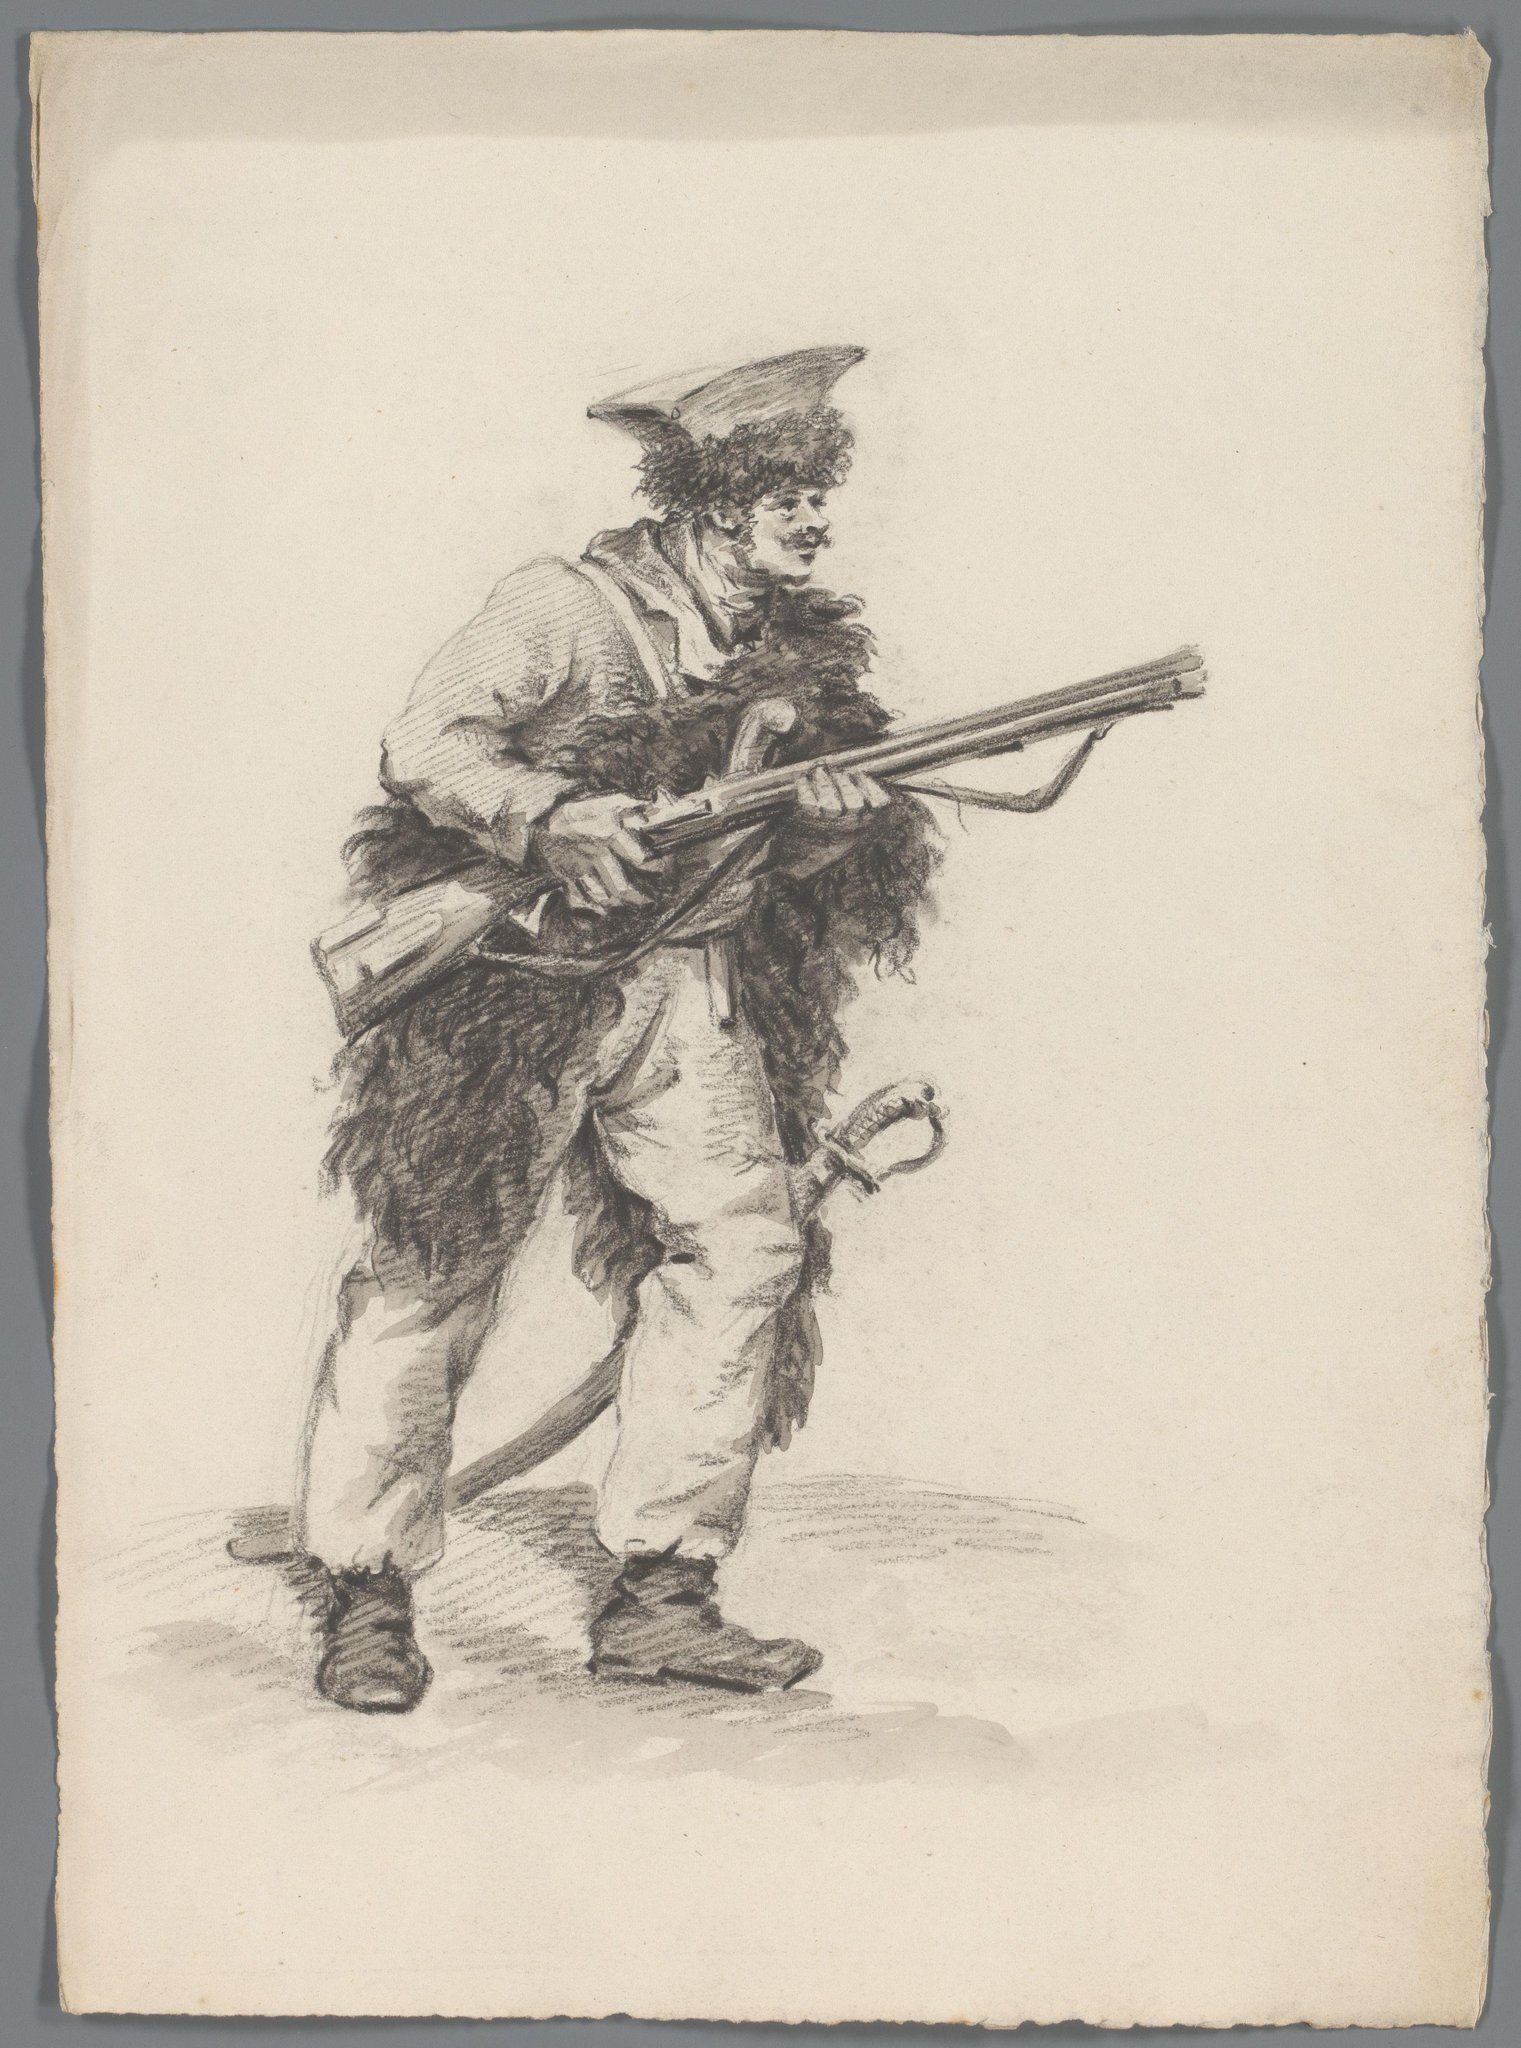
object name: drawing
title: Soldaat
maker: Anonymous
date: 1820-1830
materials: chalk, paper, watercolor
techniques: brush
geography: the hague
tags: hacking and thrusting weapons: sword, the soldier; the soldier's life, firearms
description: Tekeningen waarschijnlijk ontstaan bij het Haagse kunstgenootschap ‘Tot Nut der Tekenkunst’, waar twee keer per week tekenavonden werden georganiseerd met geklede modellen.